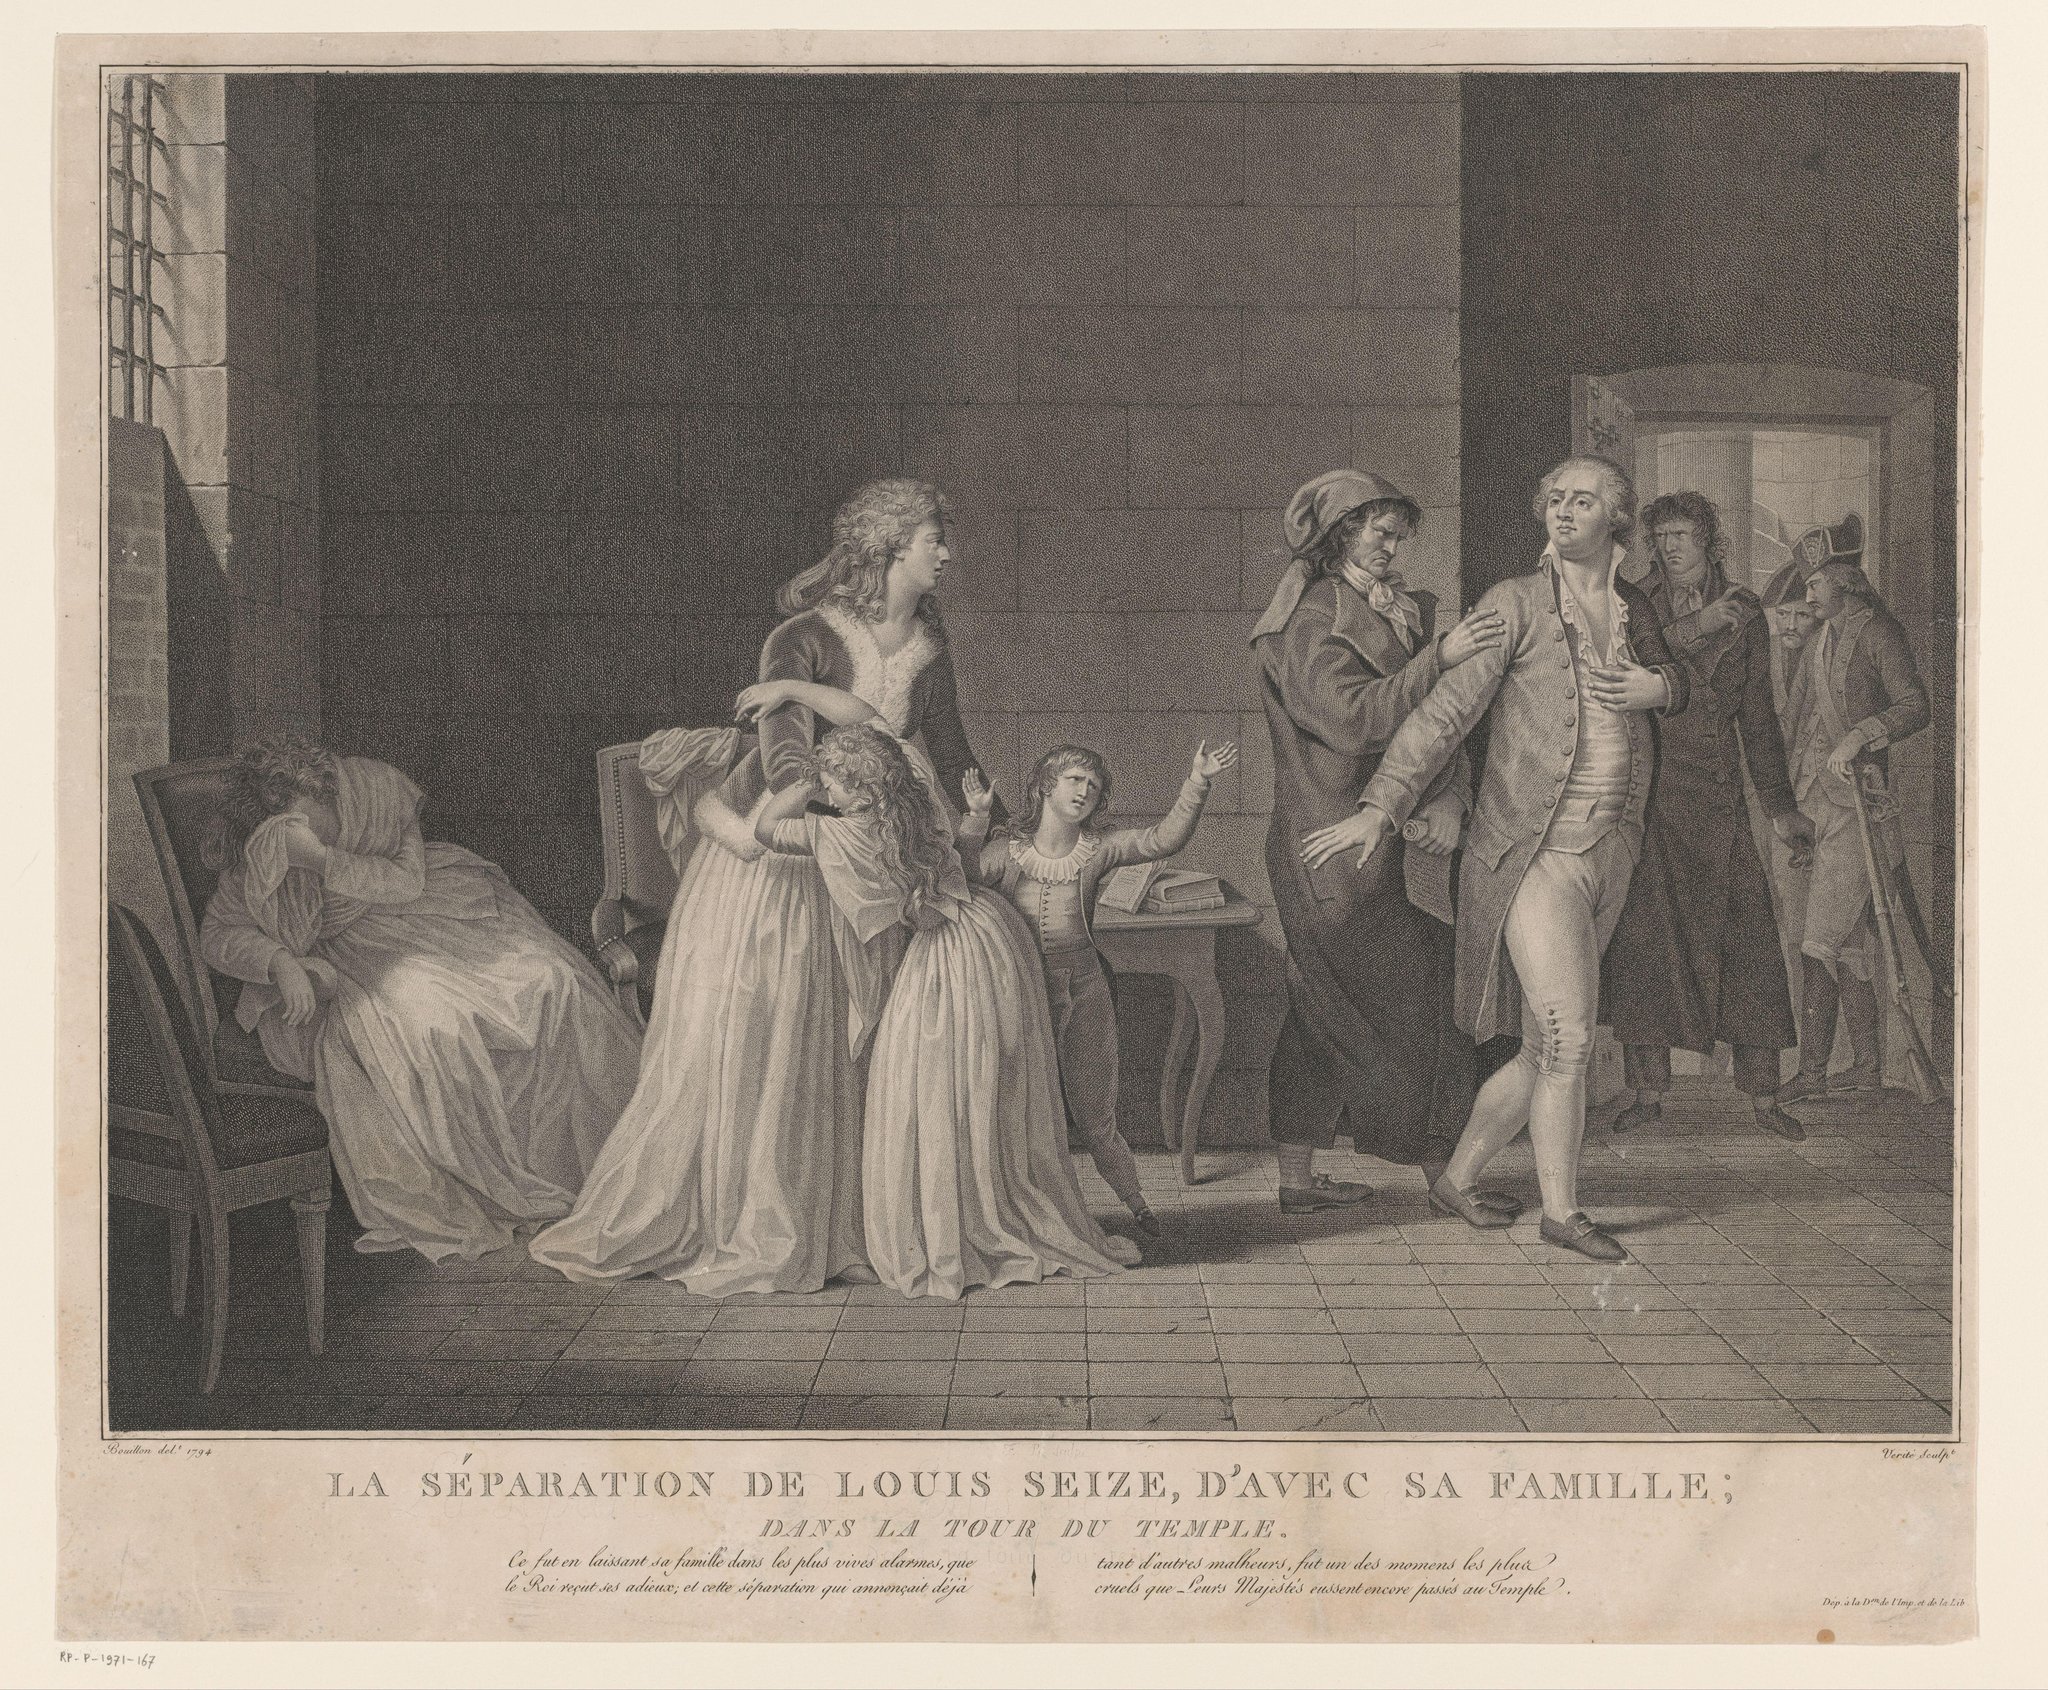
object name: print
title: La séparation de Louis seize, d'avec sa famille; dans la tour du temple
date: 1794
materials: paper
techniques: engraving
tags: marie thérèse charlotte van frankrijk, lodewijk xvi (koning van frankrijk), vienna, paris, marie antoinette, prison, jail, historical persons, king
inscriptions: : ‘Dép à la D.en de l'Imp. et de la Lib.’, collector's mark: Lugt 2228, collector's mark: Lugt 2760